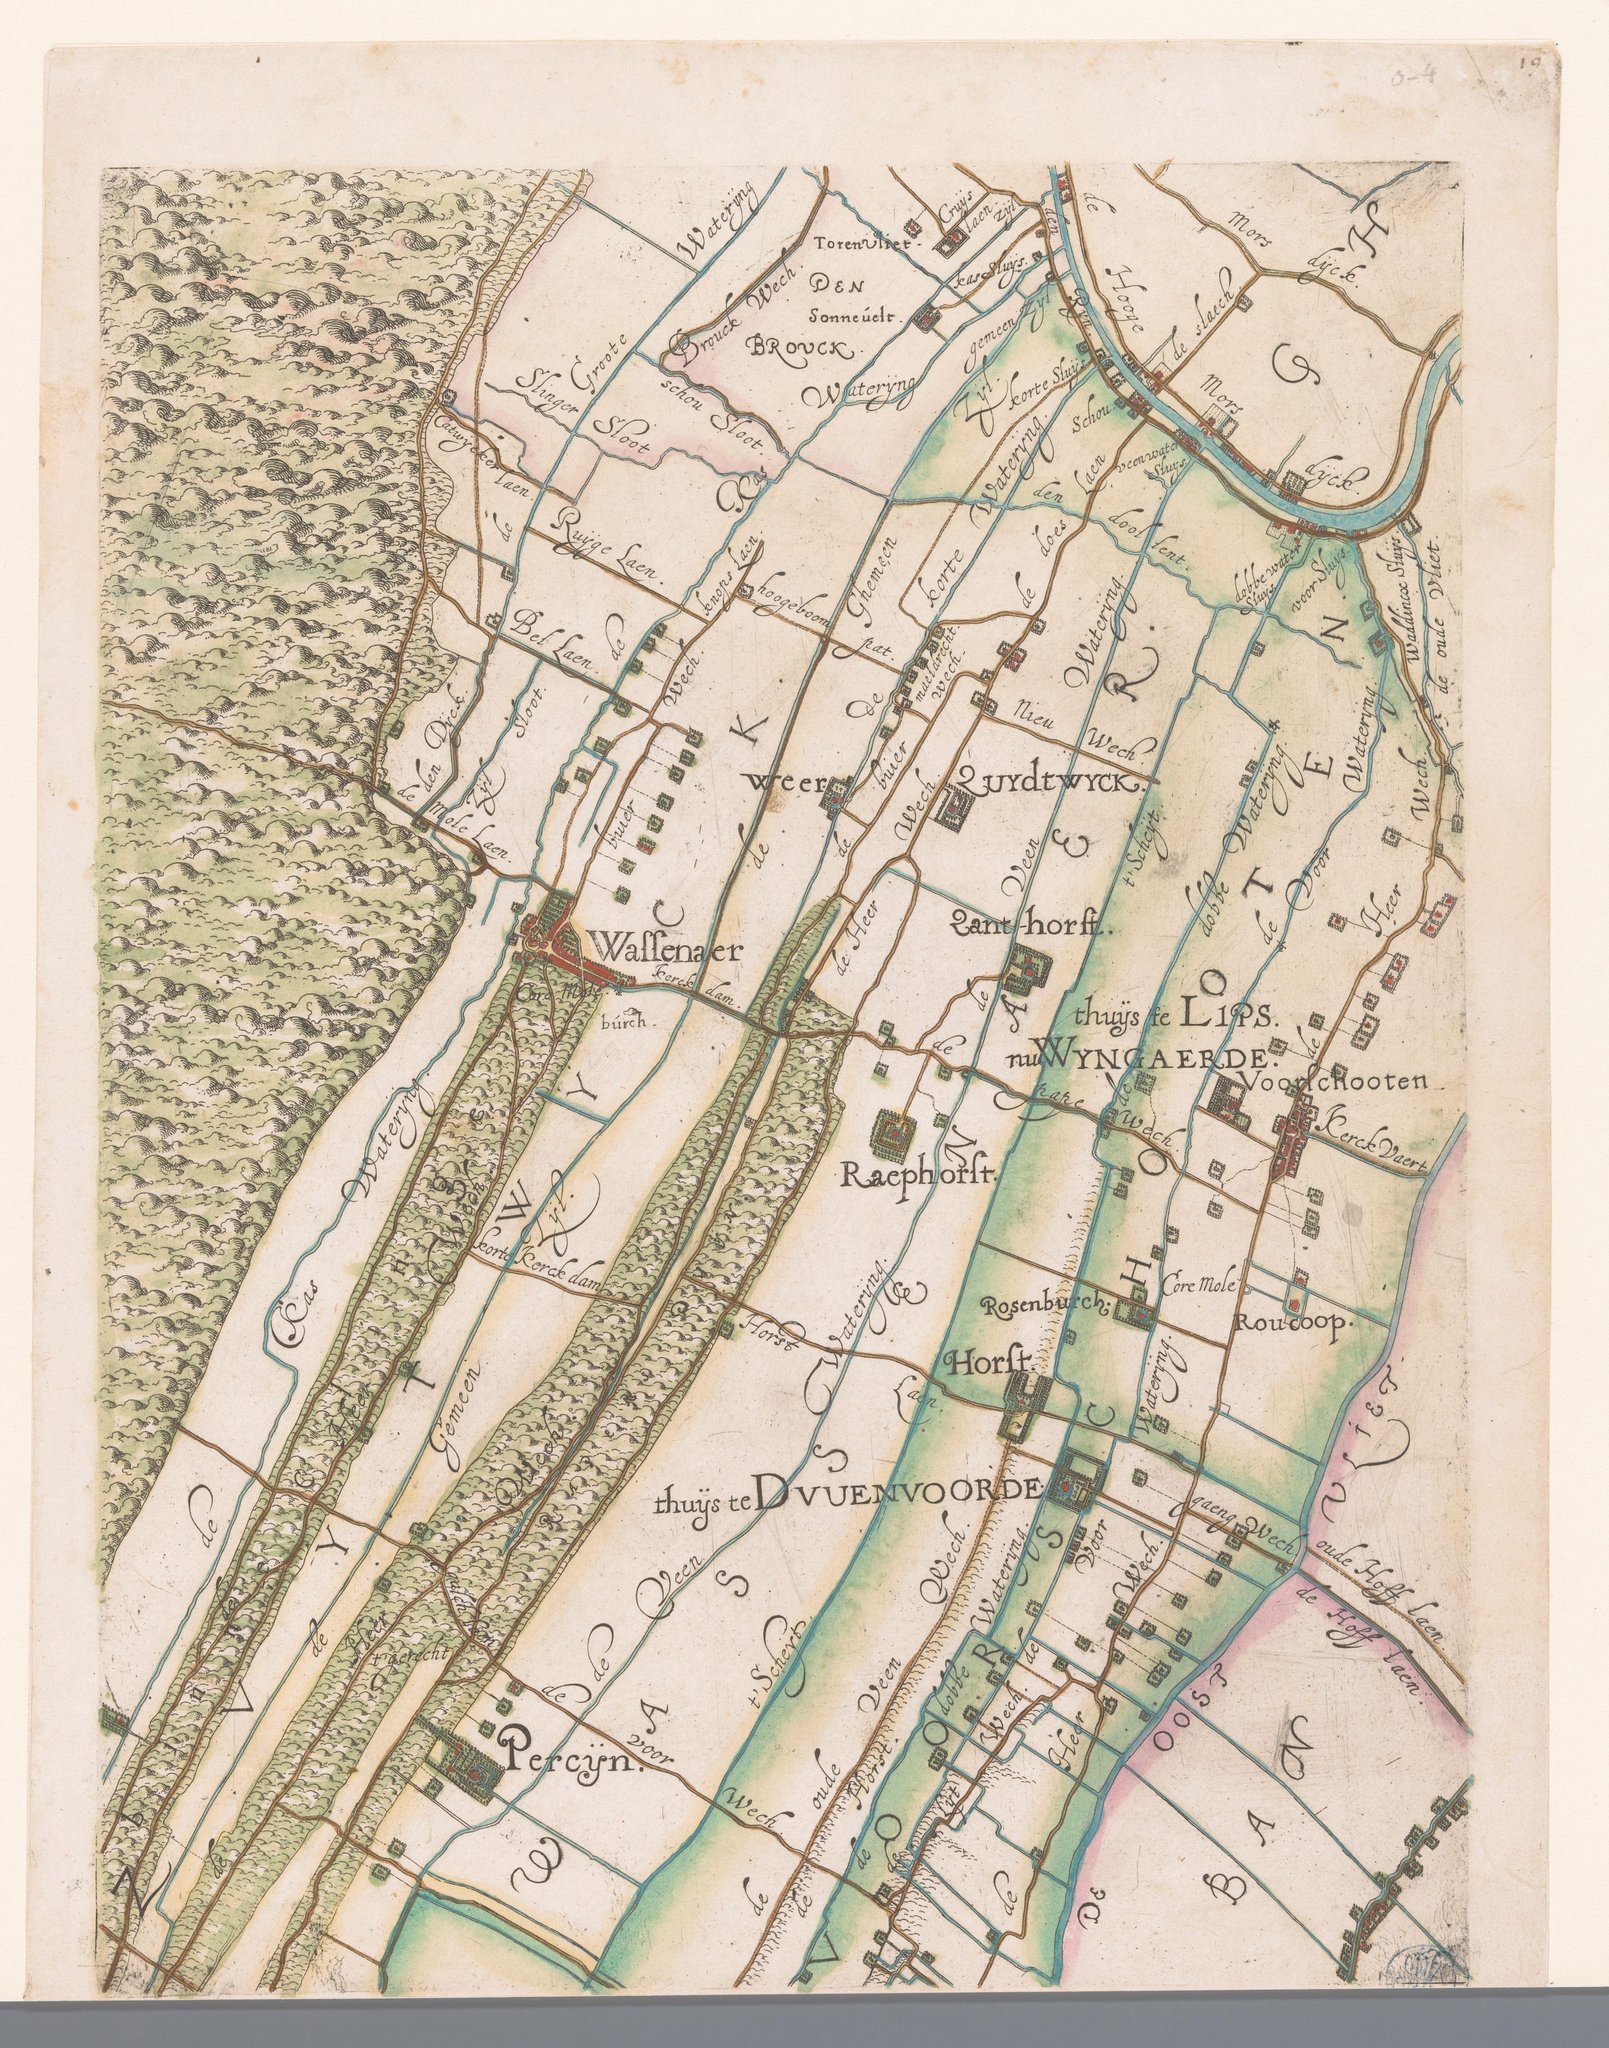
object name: print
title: Deel van een kaart van het Hoogheemraadschap van Rijnland, met Wassenaar en omgeving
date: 1615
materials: paper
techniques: engraving, etching, hand coloring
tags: maps of separate countries or regions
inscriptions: collector's mark: Lugt 195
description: Deel van een kaart van Rijnland, bestaande uit 27 delen.